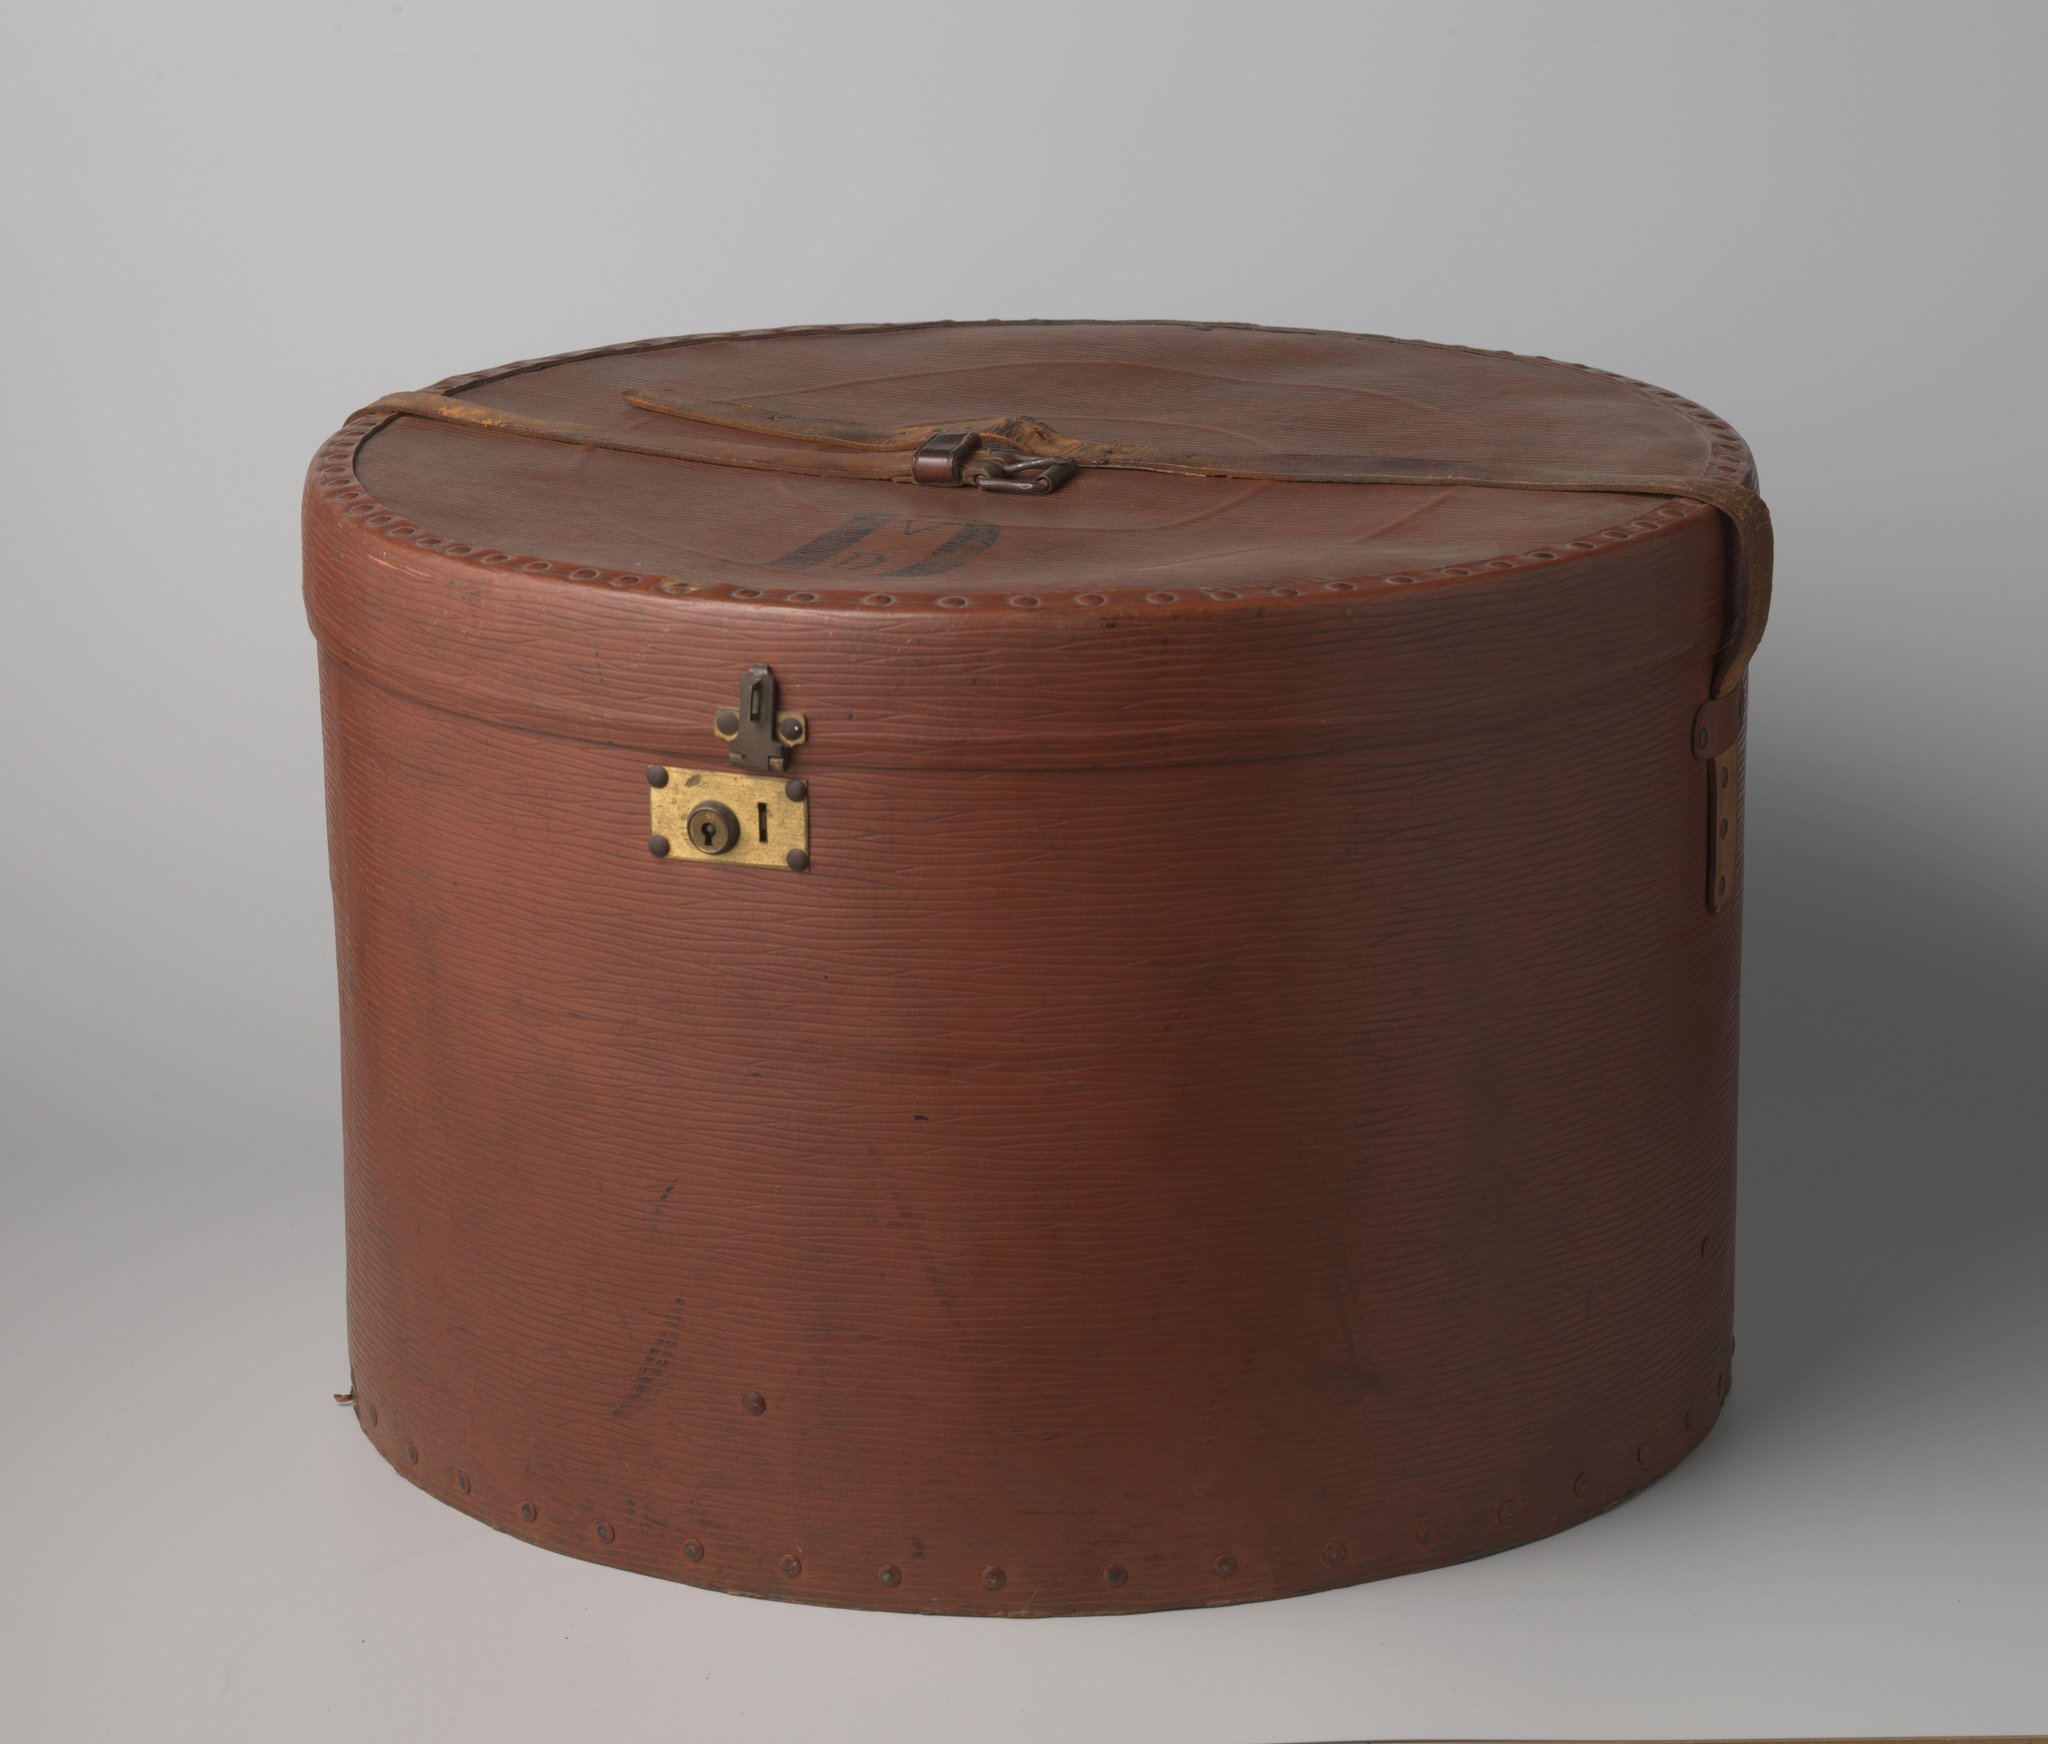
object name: hoedenkoffer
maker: Anonymous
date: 1910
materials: cardboard, leather, paper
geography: western europe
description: Een plat cilindervormige hoedenkoffer van bruin imitatieribbelleer, met een naar binnen verdiepte bodem. De binnenzijde is bekleed met papier, bedrukt met een patroon van bloemen in zwart, geel, wit en blauw. Het deksel is aan de doos bevestigd met een scharnier. De doos kan worden gesloten door middel van een riem met gesp. Verder zit er ook een slot op de doos. Op de deksel de familieinitialen van Van der Does.